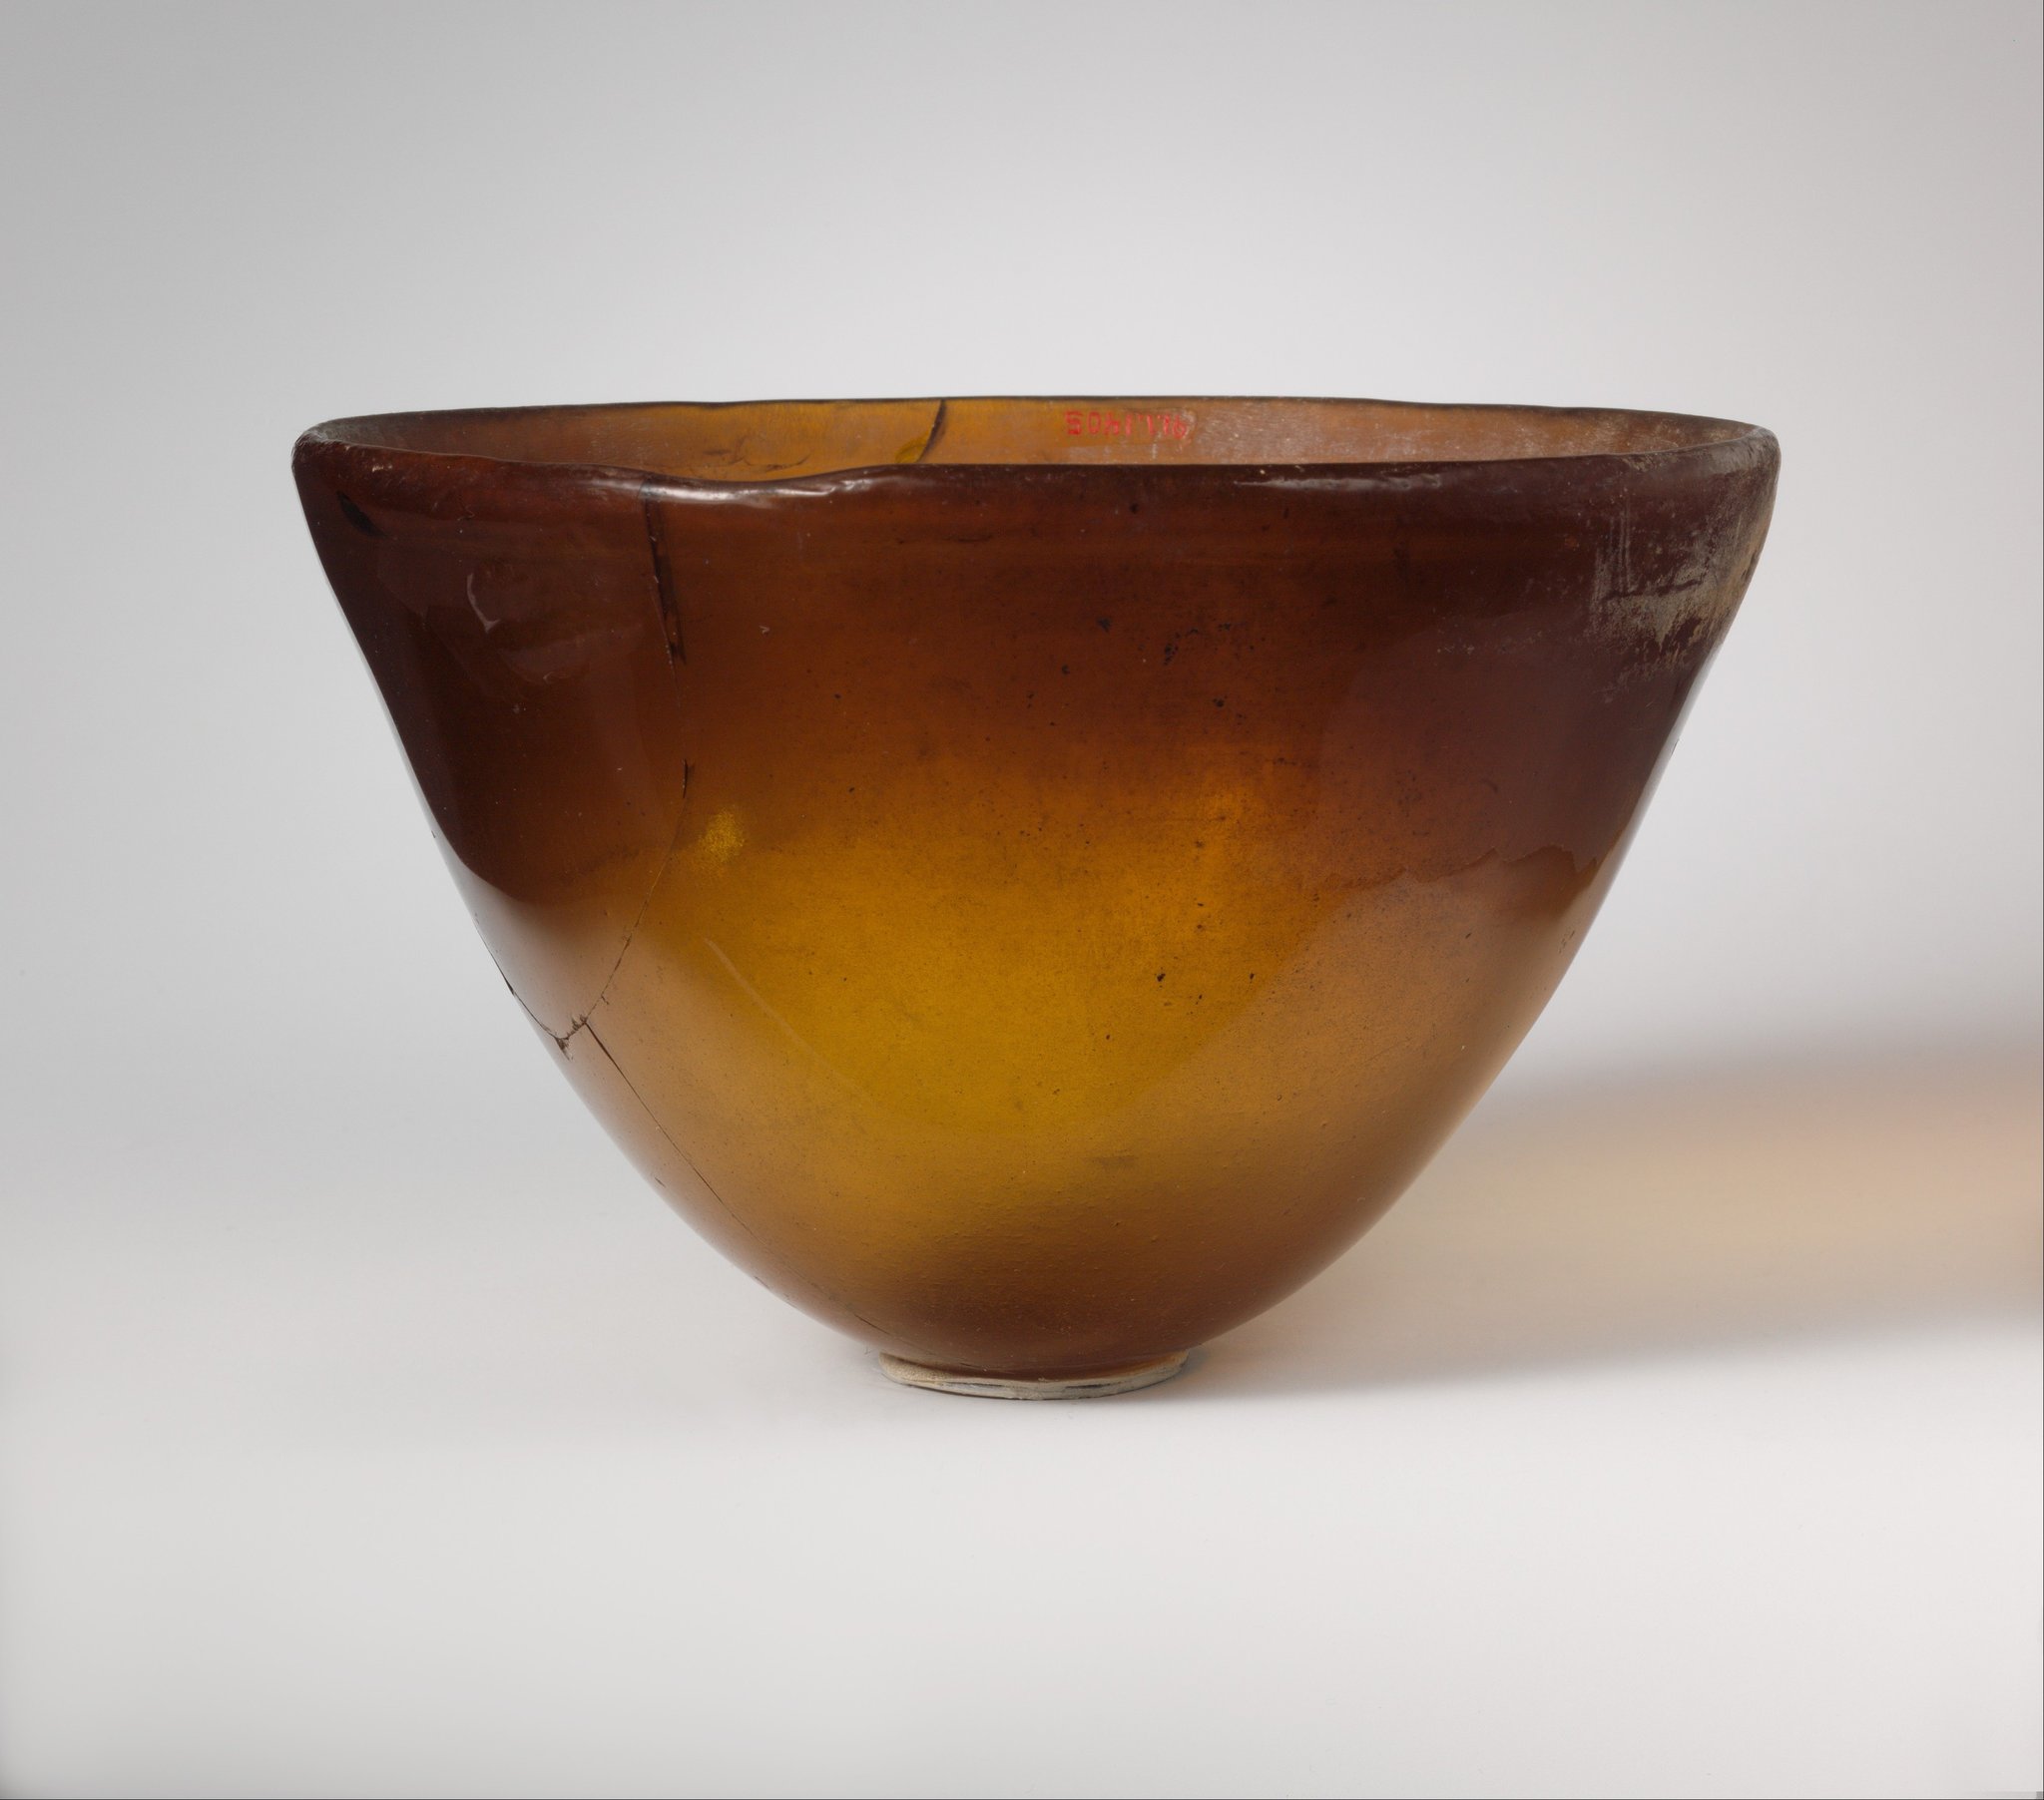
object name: bowl, mastos shaped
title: Glass conical bowl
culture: greek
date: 167-68 BCE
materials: glass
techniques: casting, cutting